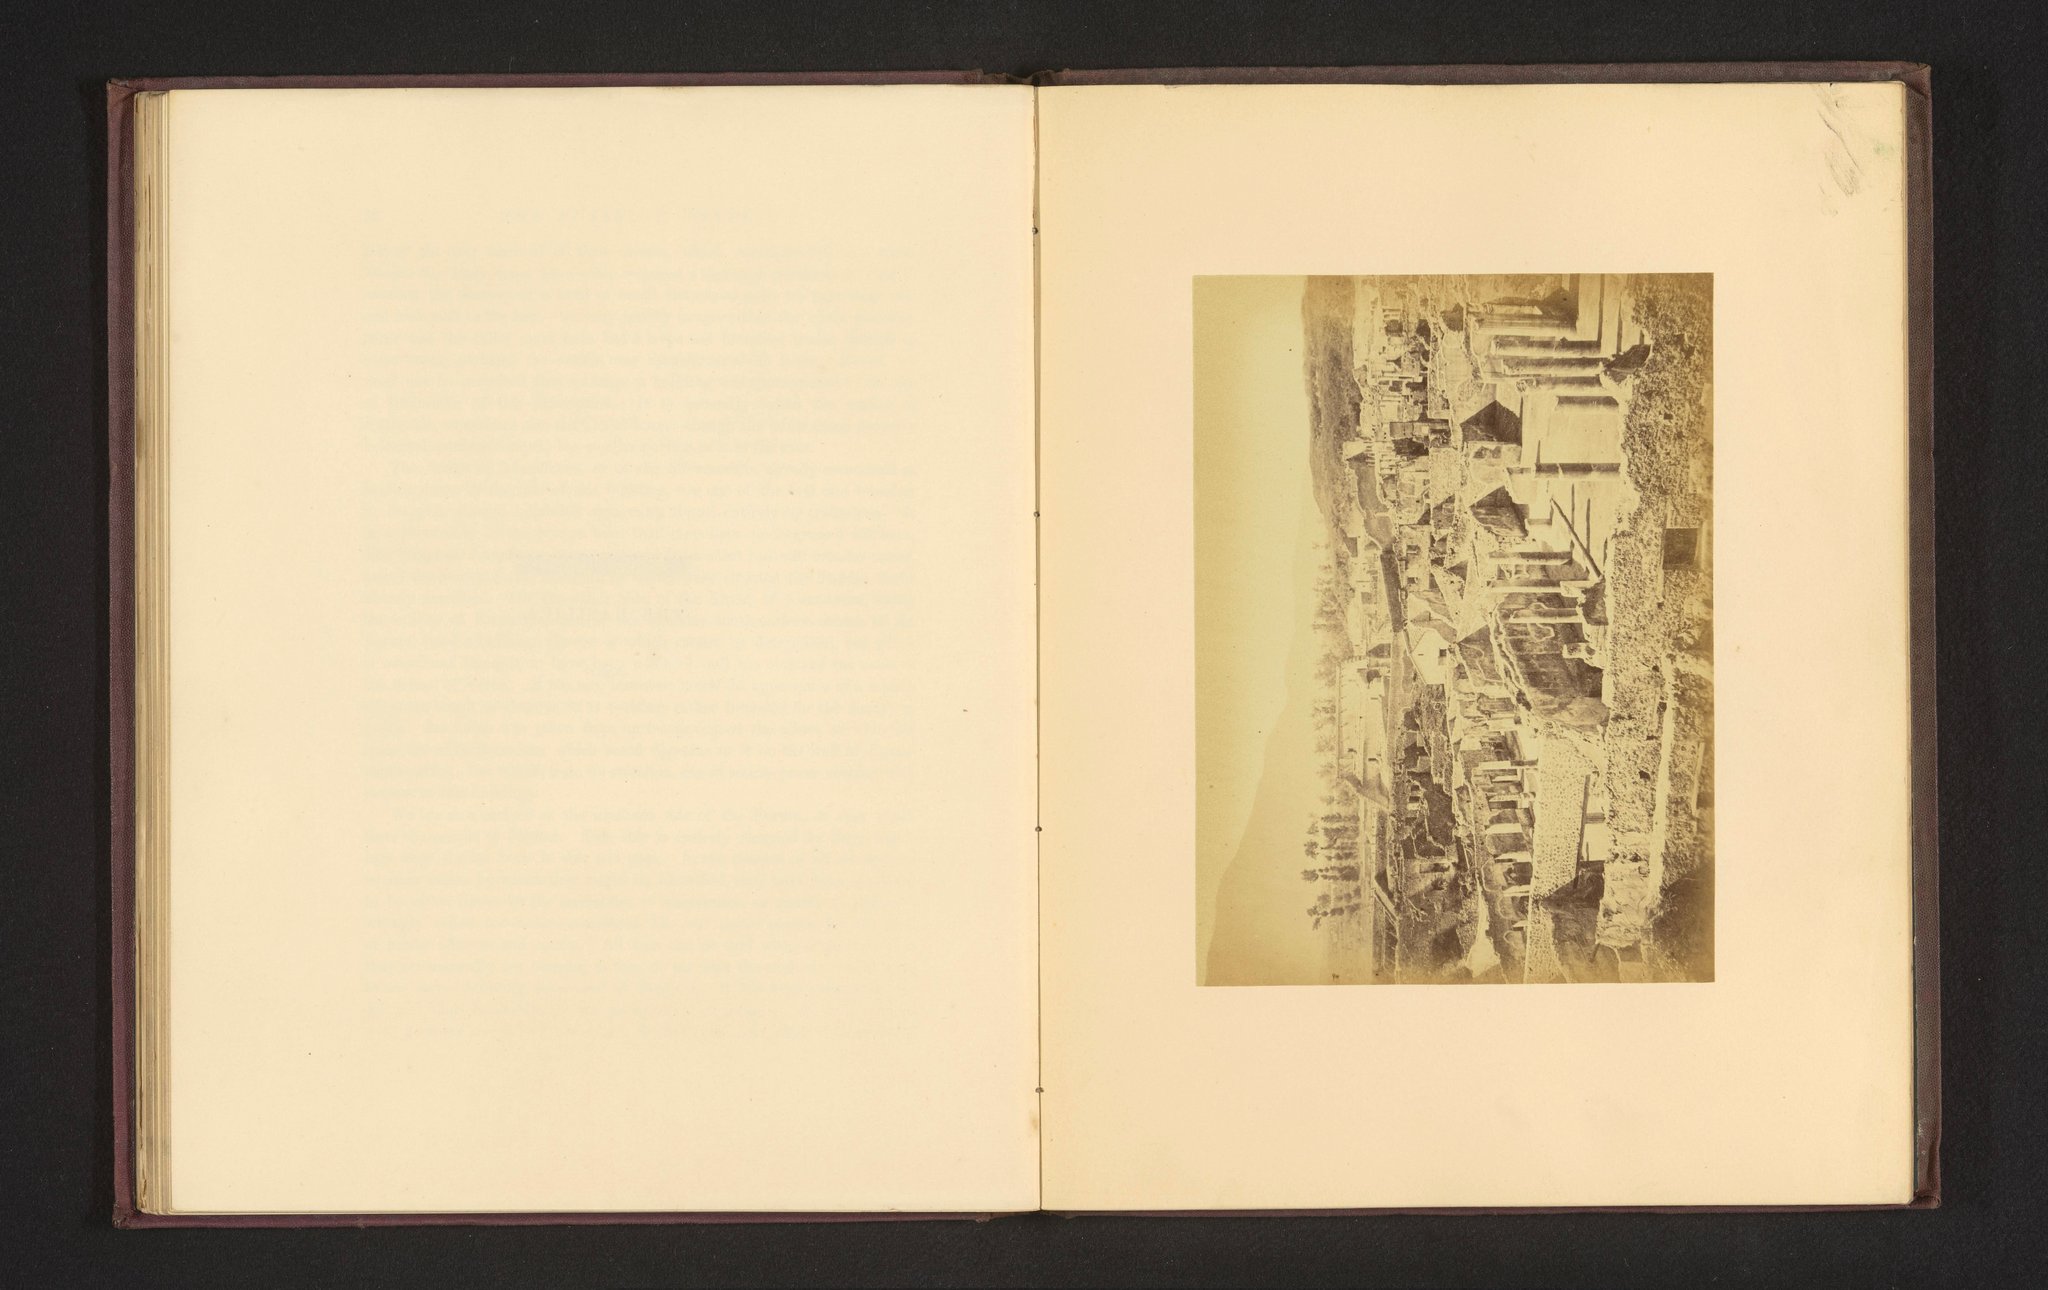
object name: photograph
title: Gezicht op de ruïnes te Pompeï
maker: Anonymous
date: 1862-1867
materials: cardboard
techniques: albumen print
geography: pompeii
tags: ruin of a building ~ architecture, pompeii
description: Foto op derde ongenummerde pagina na pagina 62.